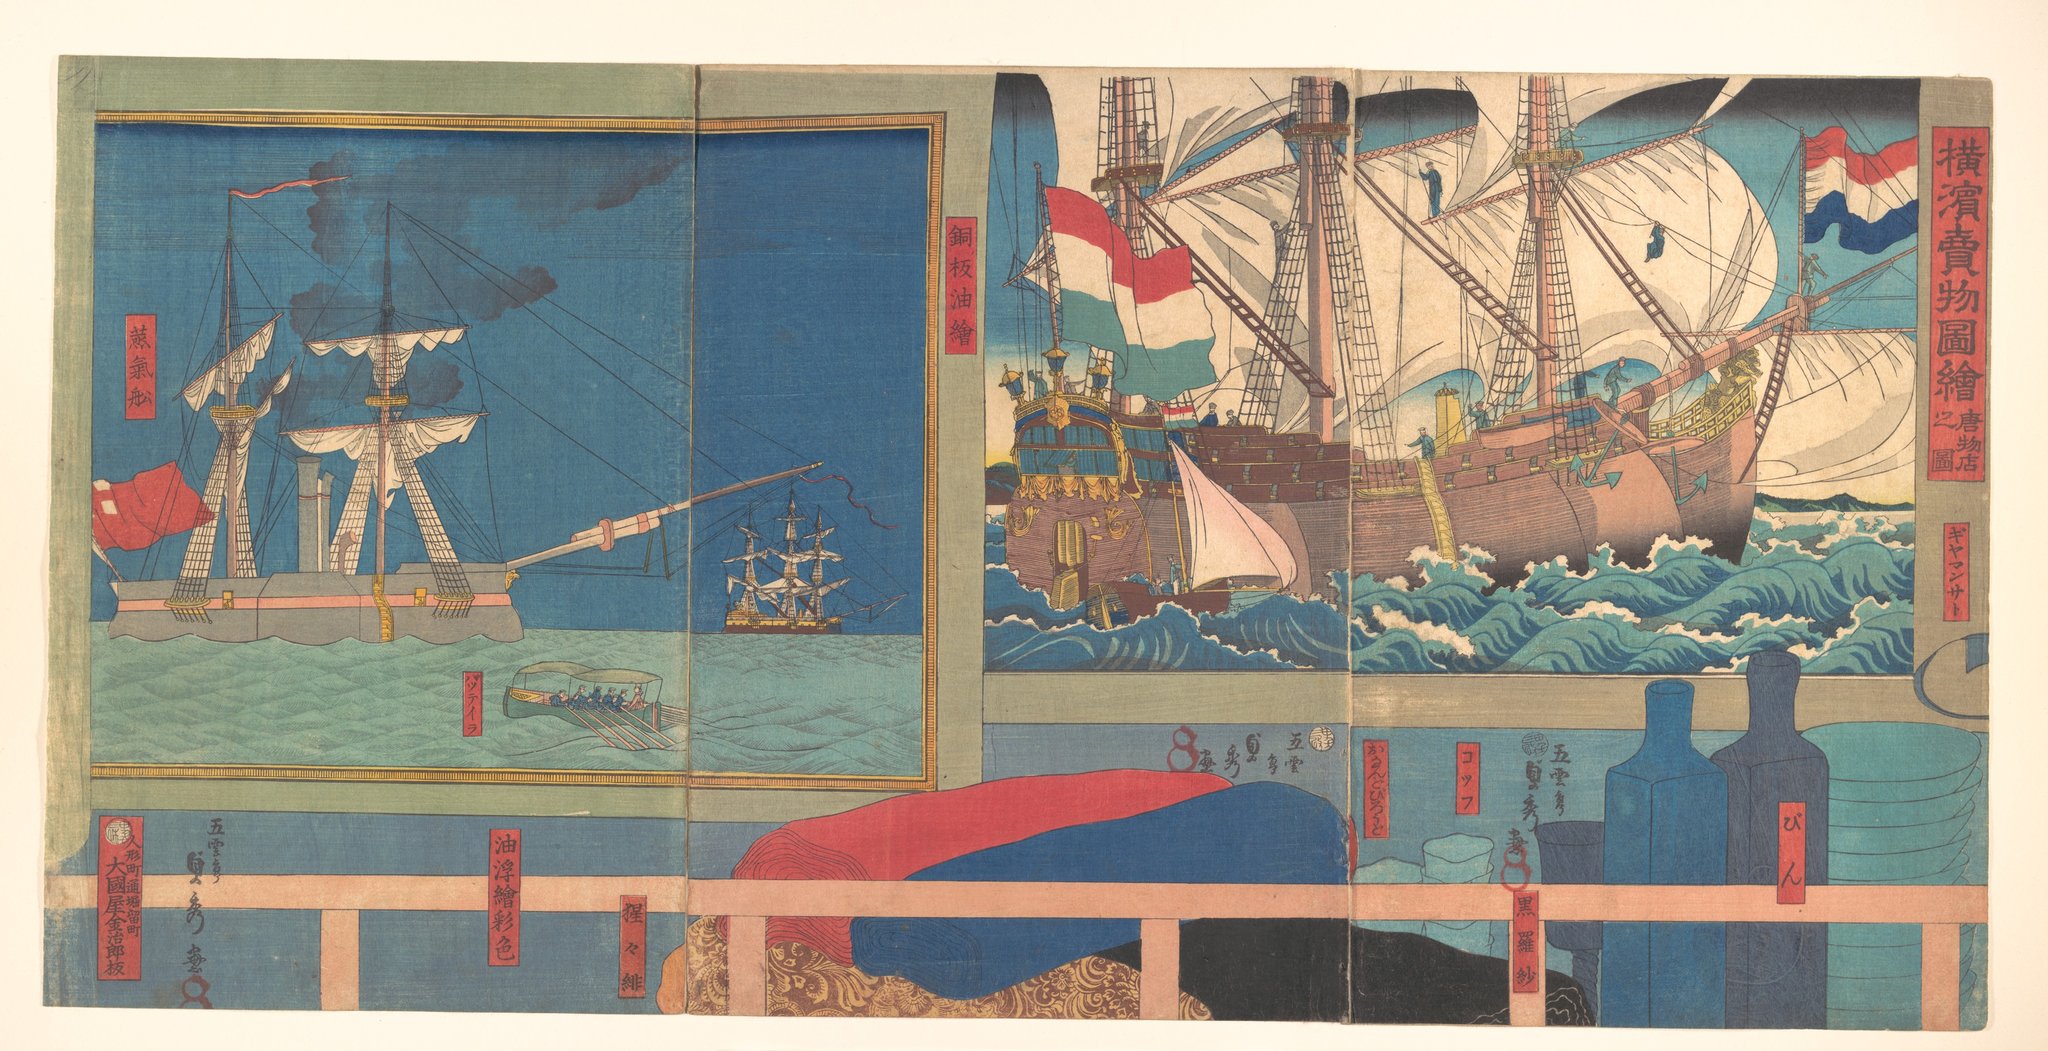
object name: print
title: Curio Shop in Yokohama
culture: japanese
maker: utagawa (gountei) sadahide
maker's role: artist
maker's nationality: japanese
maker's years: 1807-1873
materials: ink, paper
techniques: woodblock print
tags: waves,flags,ships